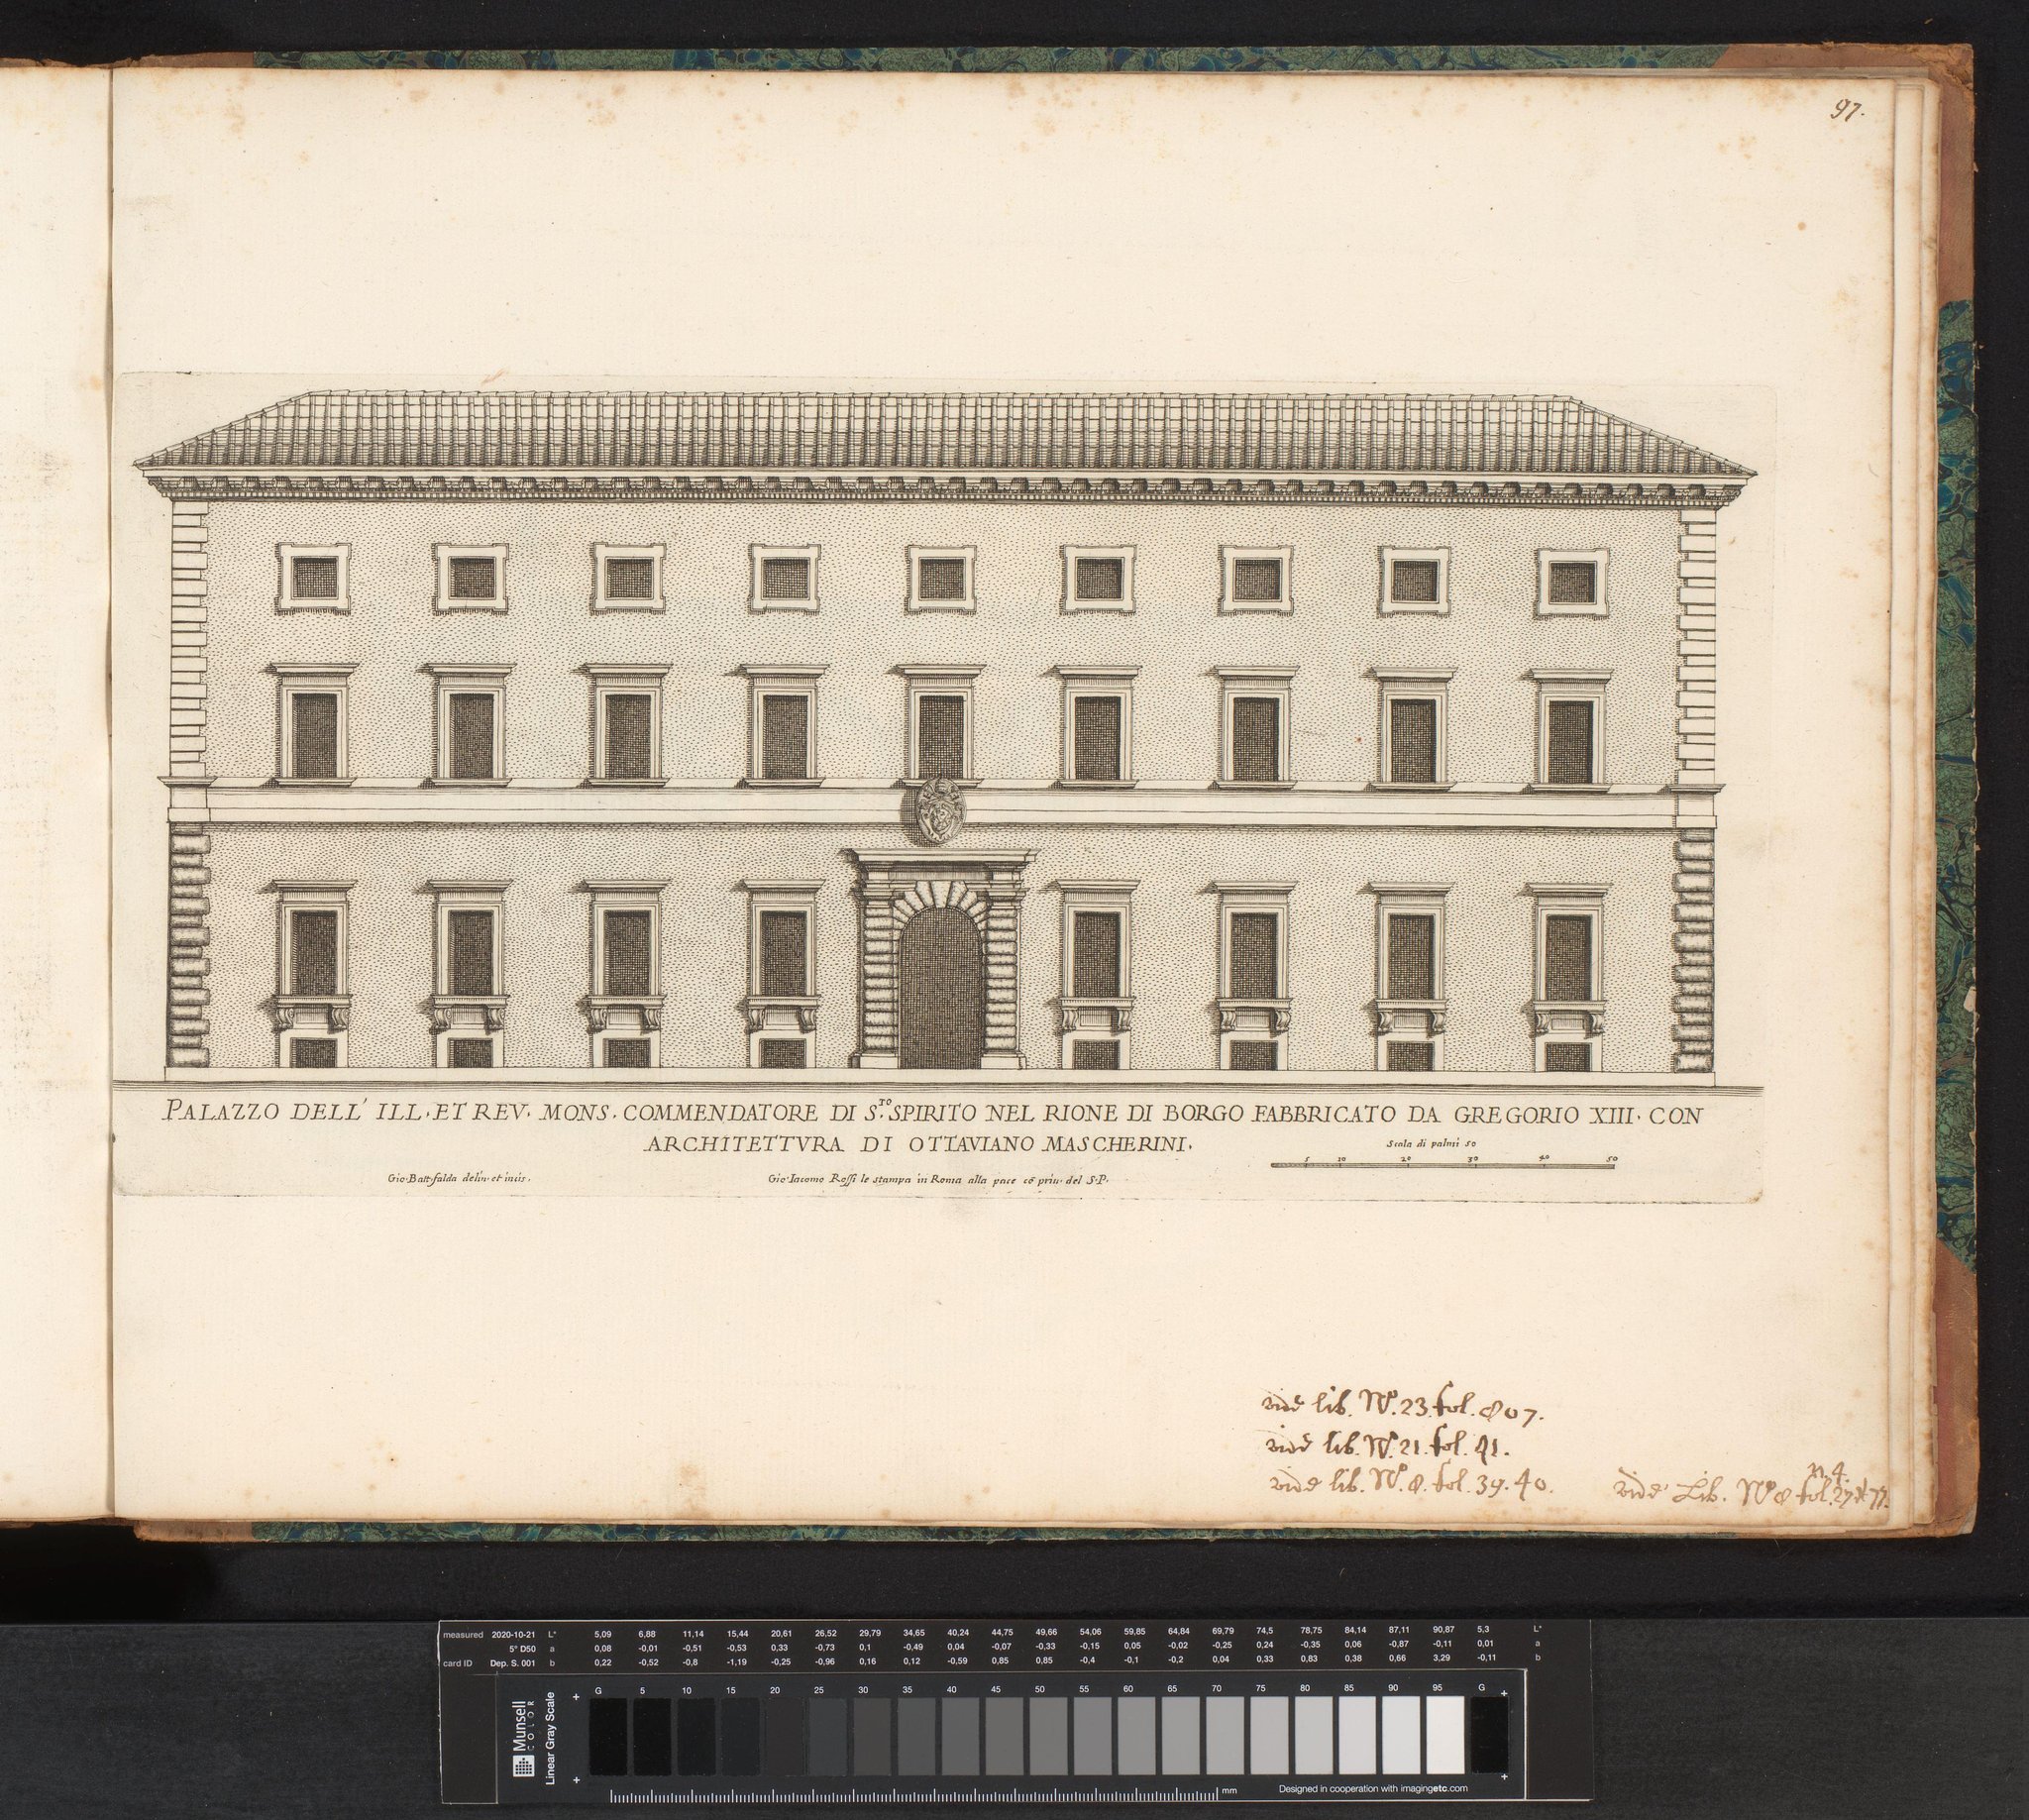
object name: album leaf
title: Palazzo dell' ill. et rev. mons. commendatore di S.to Spirito nel Rione di Borg (...)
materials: paper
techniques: etching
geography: italy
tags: rome, gregorius xiii, palace, façade (of house or building)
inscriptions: number: ‘97’, inscription: ‘Ende lib. No. 23. fol. 807./ Ende lib. No. 21. fol. 41...’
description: Deze prent maakt deel uit van de reeks getiteld: Palazzi di Roma. Deze reeks bestaat uit twee boeken. Boek één getiteld: Palazzi di Roma dei più celebri architetti..., bestaat uit 44 prenten die worden toegeschreven aan Giovanni Battista Falda (naam staat enkel op prent 27) en uitgegeven door Giovanni Giacomo de'Rossi. Deze 44 prenten zijn bekend in twee staten (met en zonder nummer). Boek twee getiteld: Nuovi disegni dell'architetture... libro secondo, bevat 66 prenten door Giovanni Battista Falda en Simone Felice. Deze 66 prenten zijn bekend in twee staten (met en zonder nummer).